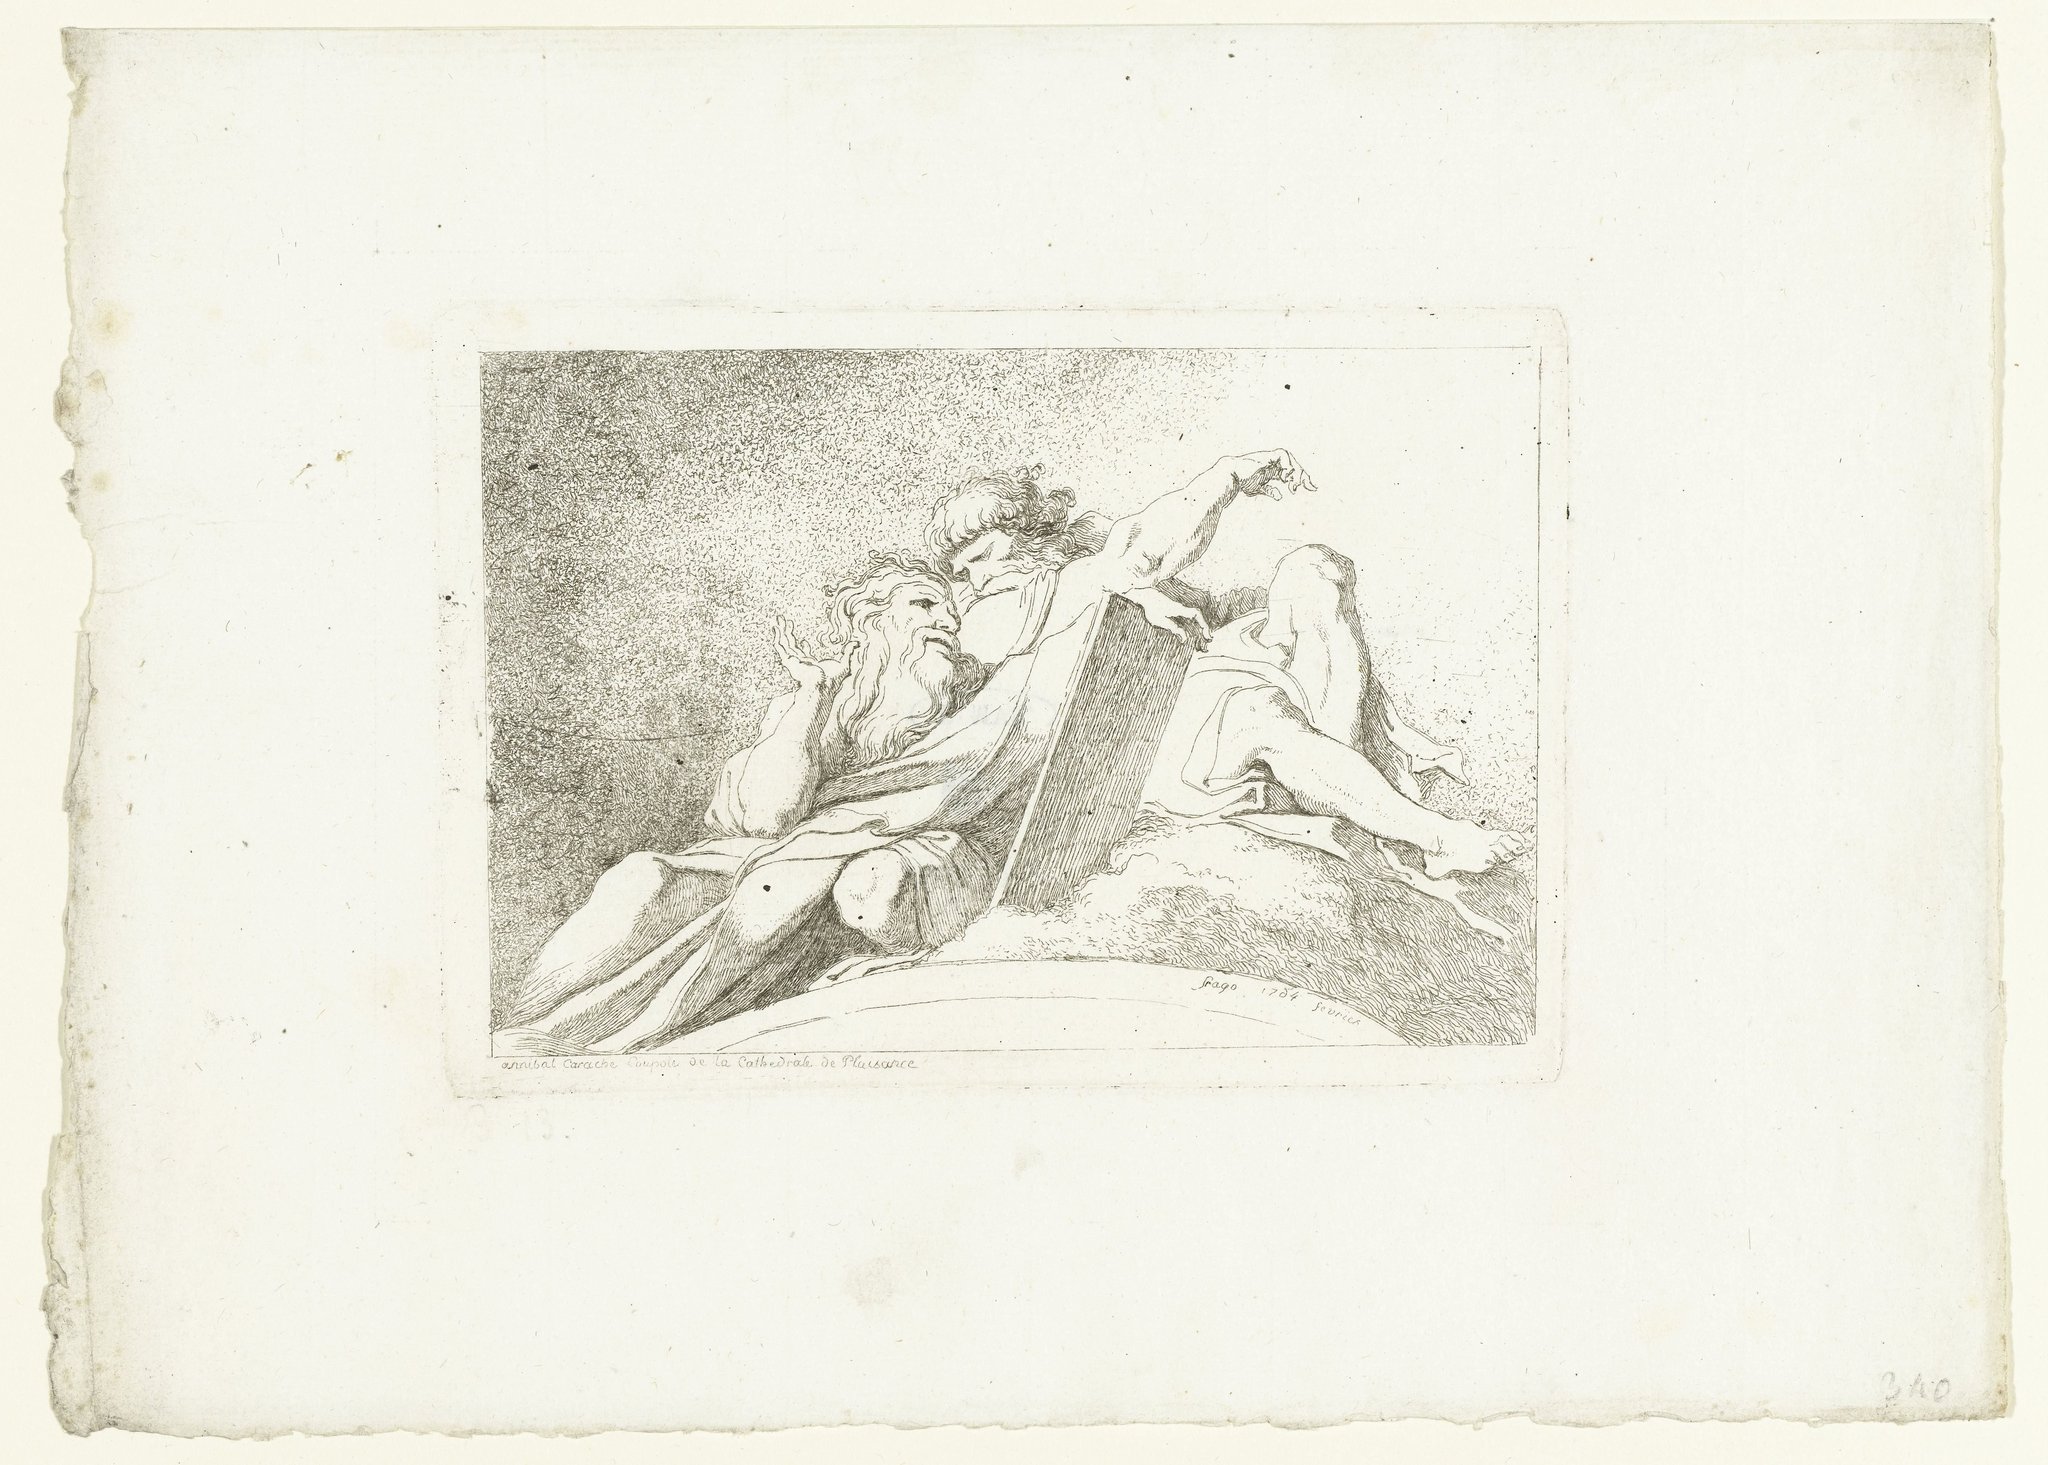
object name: print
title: Twee profeten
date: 1702-1764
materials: paper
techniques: etching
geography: piacenza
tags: male persons from the old testament (not in biblical context)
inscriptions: collector's mark: Lugt 2760, inscription: ‘annibal carache Coupole de la Cathedrale de Plaisance’, collector's mark: Lugt 2228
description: Twee profeten met een tableau, zittend op een wolk.